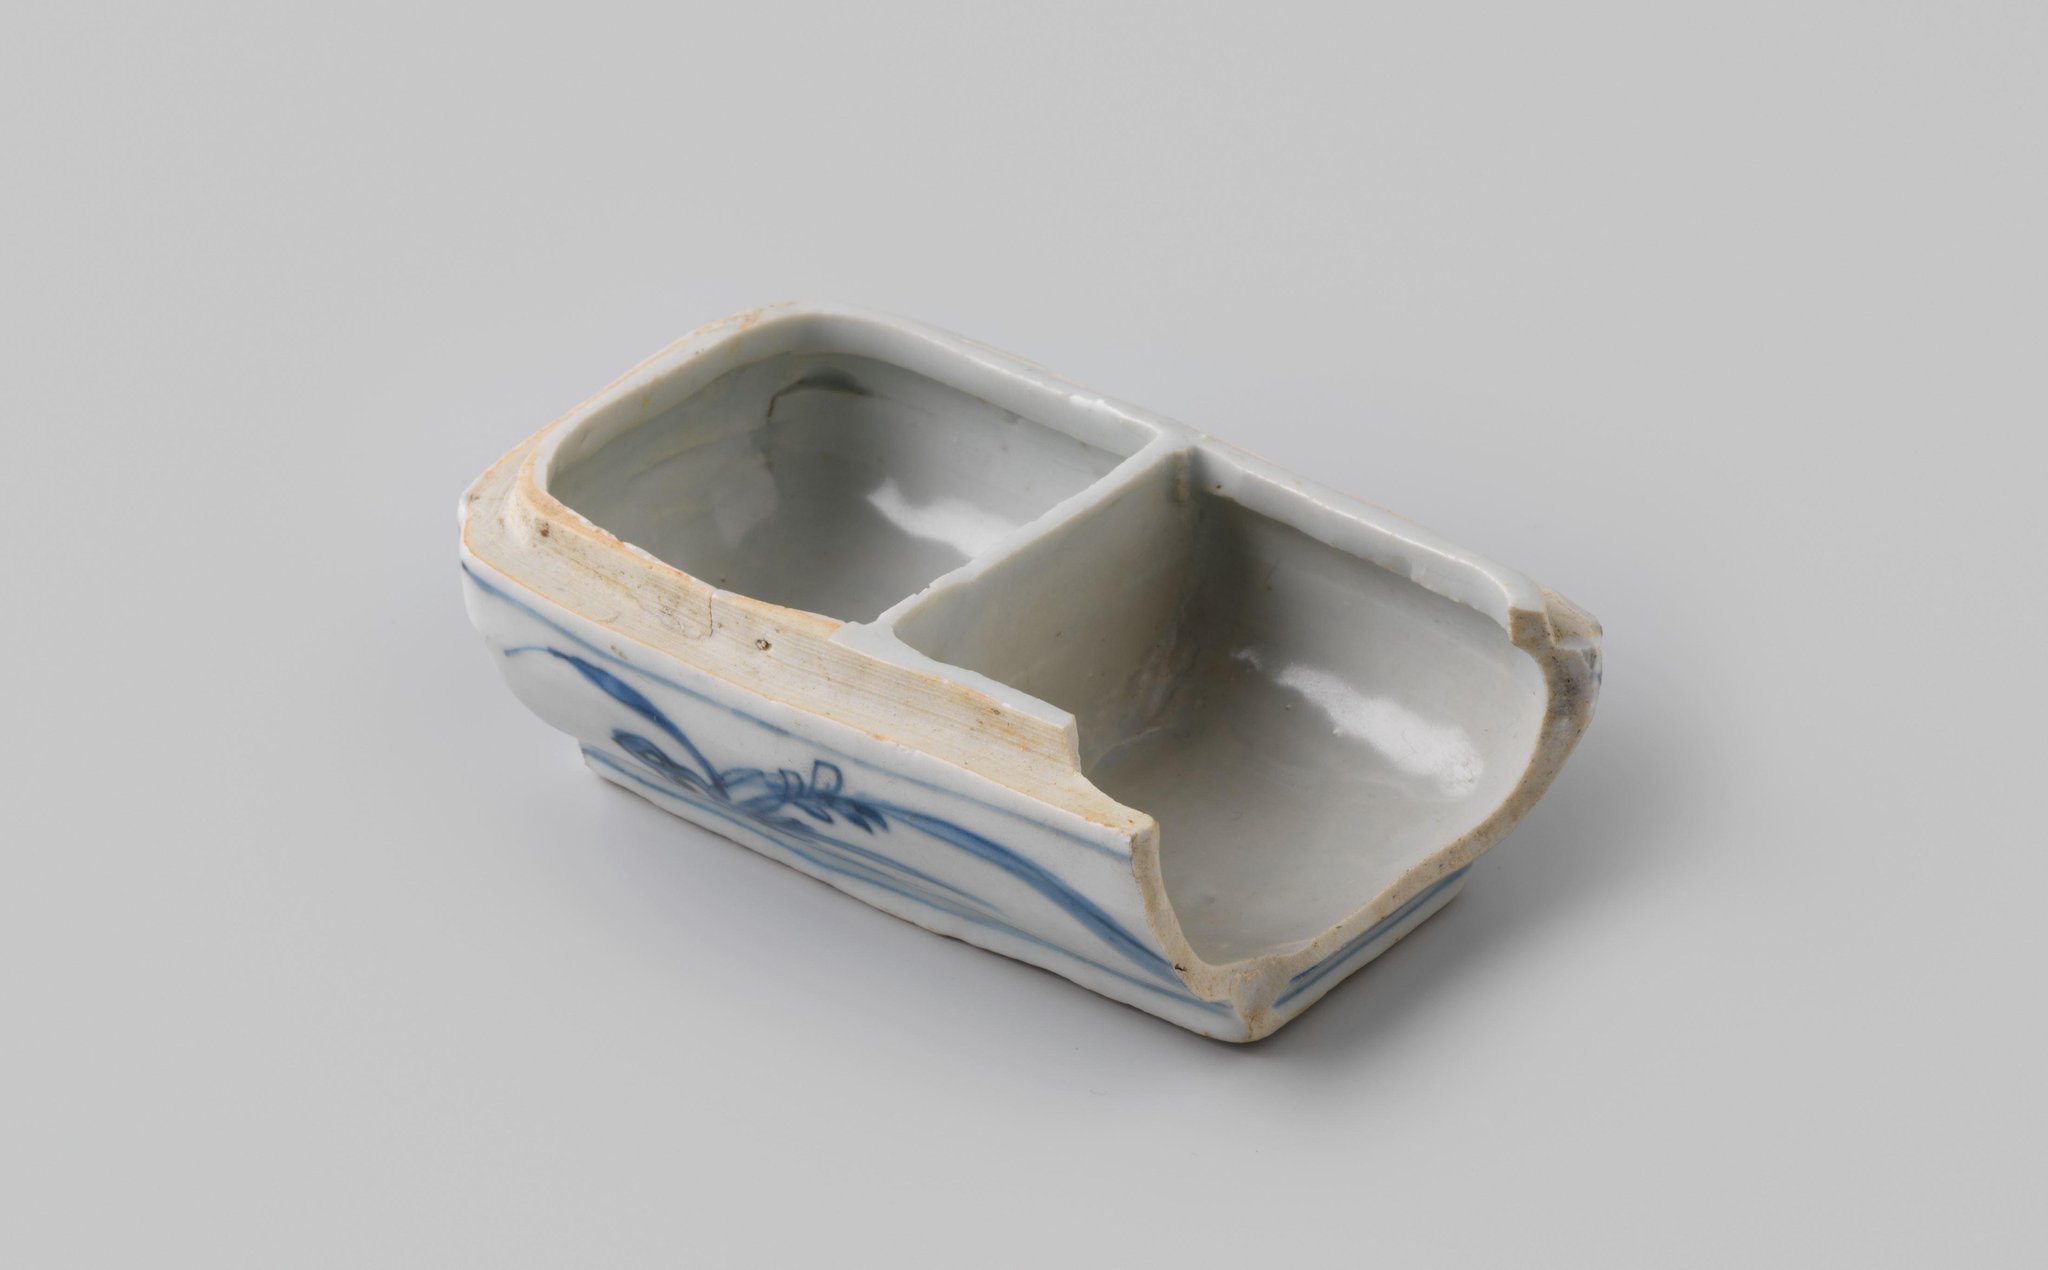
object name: box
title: Doos uit V.O.C.-schip de 'Witte Leeuw'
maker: Anonymous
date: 1613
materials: bone china, porcelain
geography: jingdezhen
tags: verenigde oostindische compagnie, sint-helena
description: Doos uit V.O.C.-schip de 'Witte Leeuw', 90% bewaard: een deel van de onderkant ontbreekt. Beteldoosje van porselein met twee compartimenten, beschilderd in onderglazuurblauw met op de zijkanten ovale medaillons met bloemtakjes omgeven door een meander motief. De scherf is glasachtig wit en heeft weinig ingebakken vuil. Het glazuur is blauwgetint. De bodem is geglazuurd. De voetring is recht en gefacetteerd. Er is geen ovenzand aangetroffen. NG-1977-121-B-W is de bijbehorende deksel.